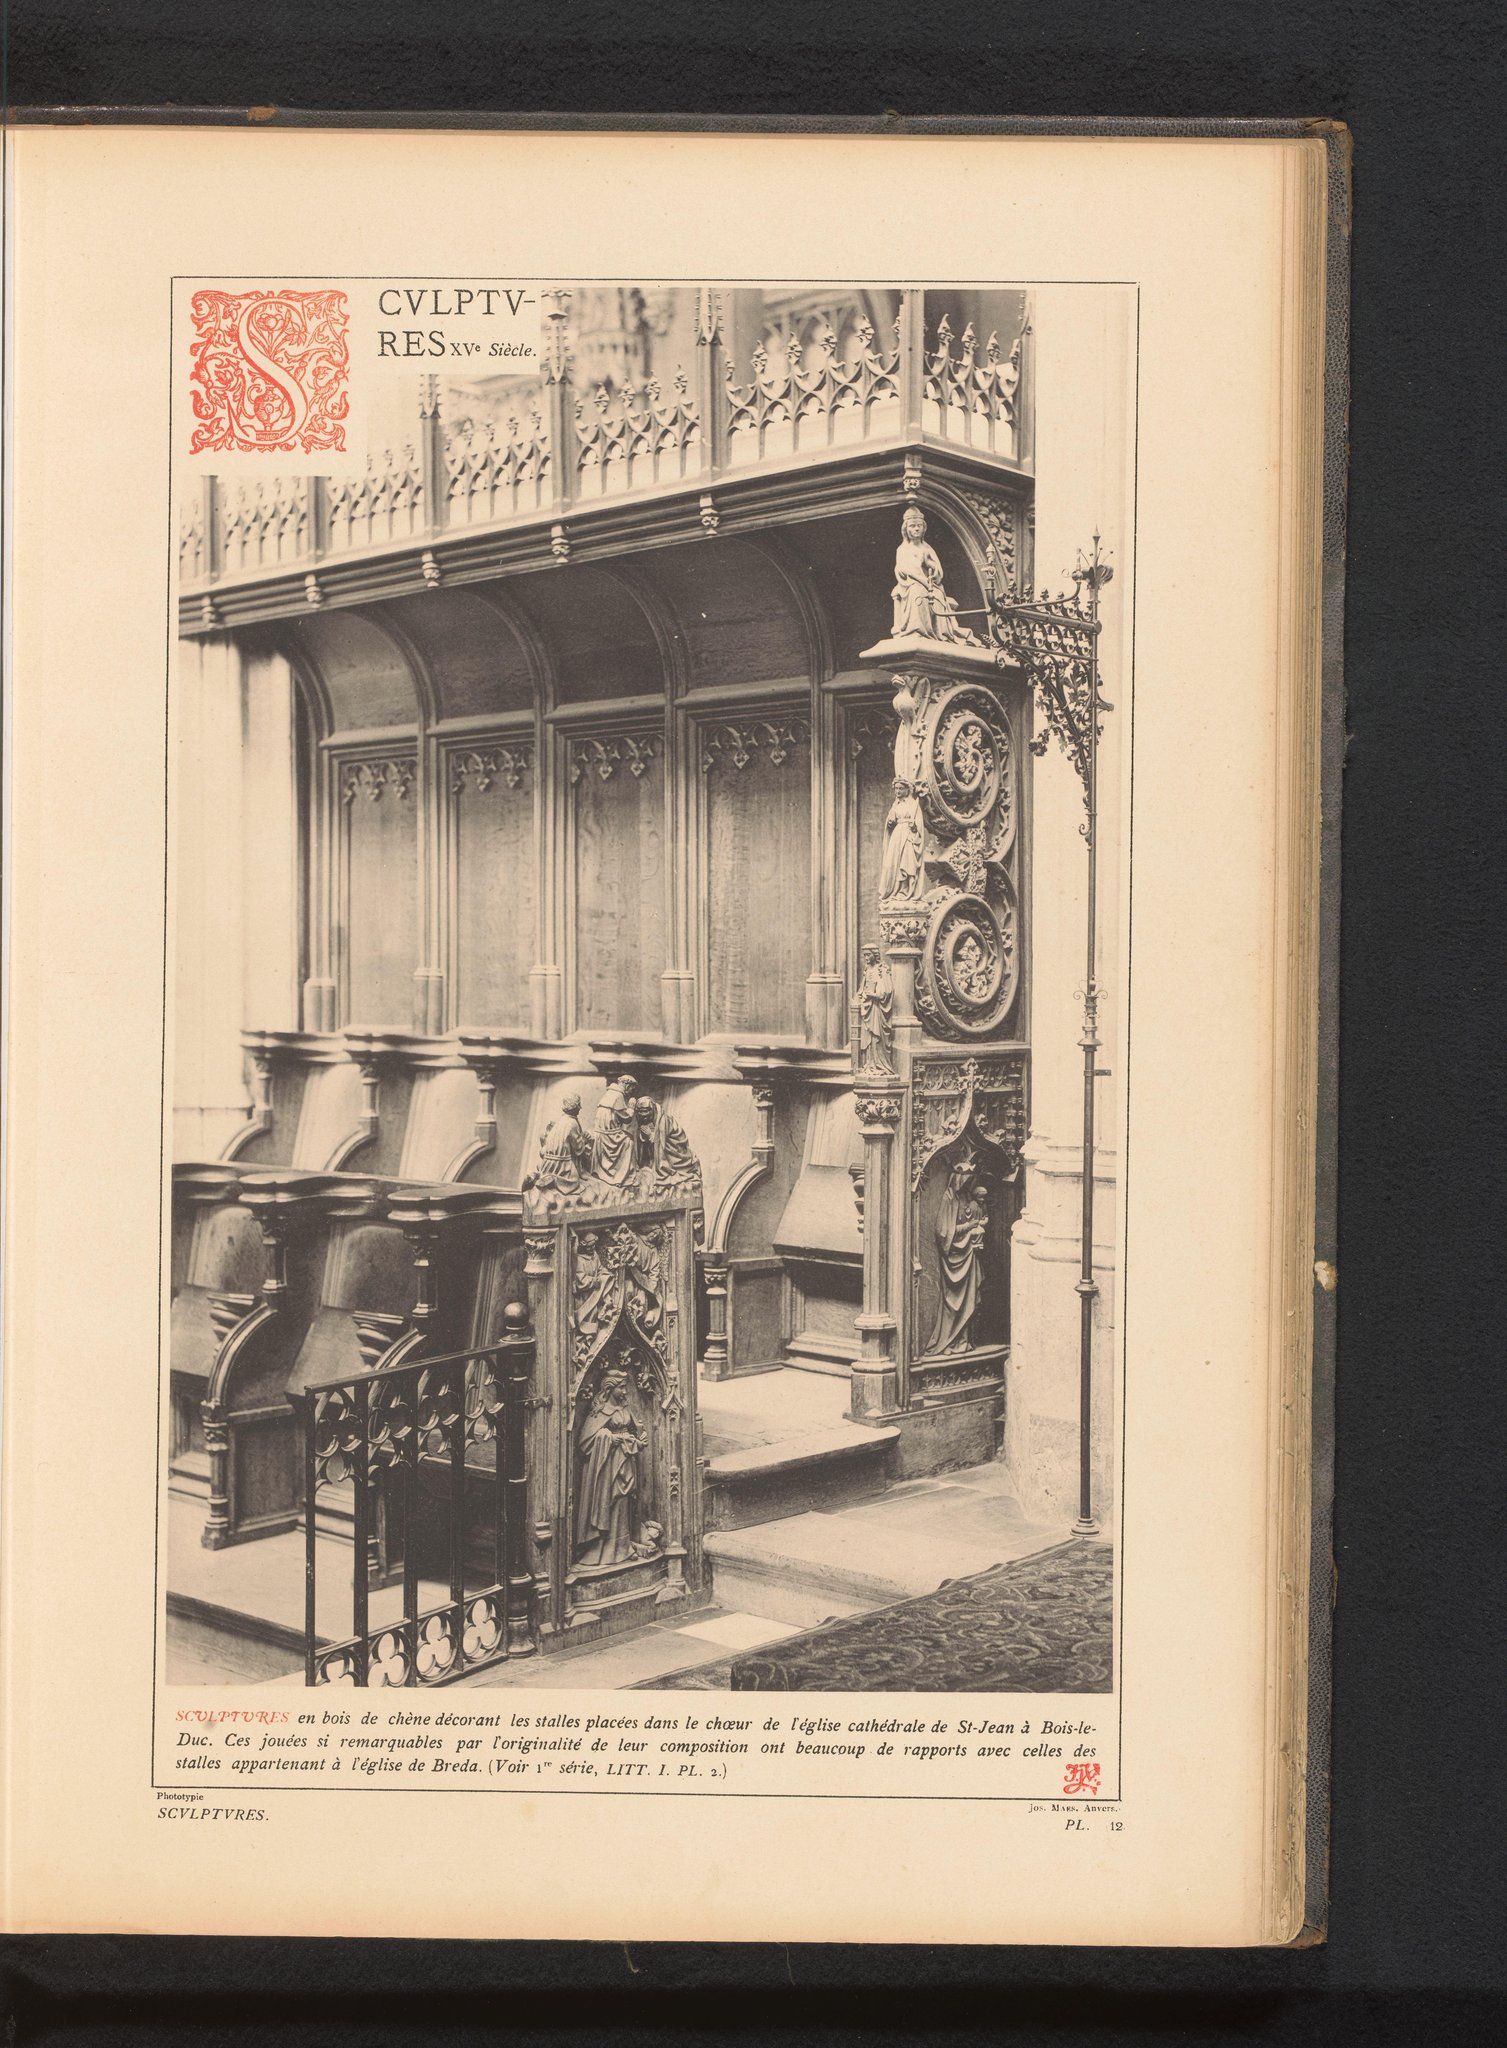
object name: page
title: Sculptures, XVe Siècle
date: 1881-1889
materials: paper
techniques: photograph, photolithography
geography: antwerp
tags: interior of church, sculpture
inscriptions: inscription: ‘SCULPTURES en bois (...)’, inscription: ‘SCULPTURES. PL. 12.’, monogram: ‘JJvY’